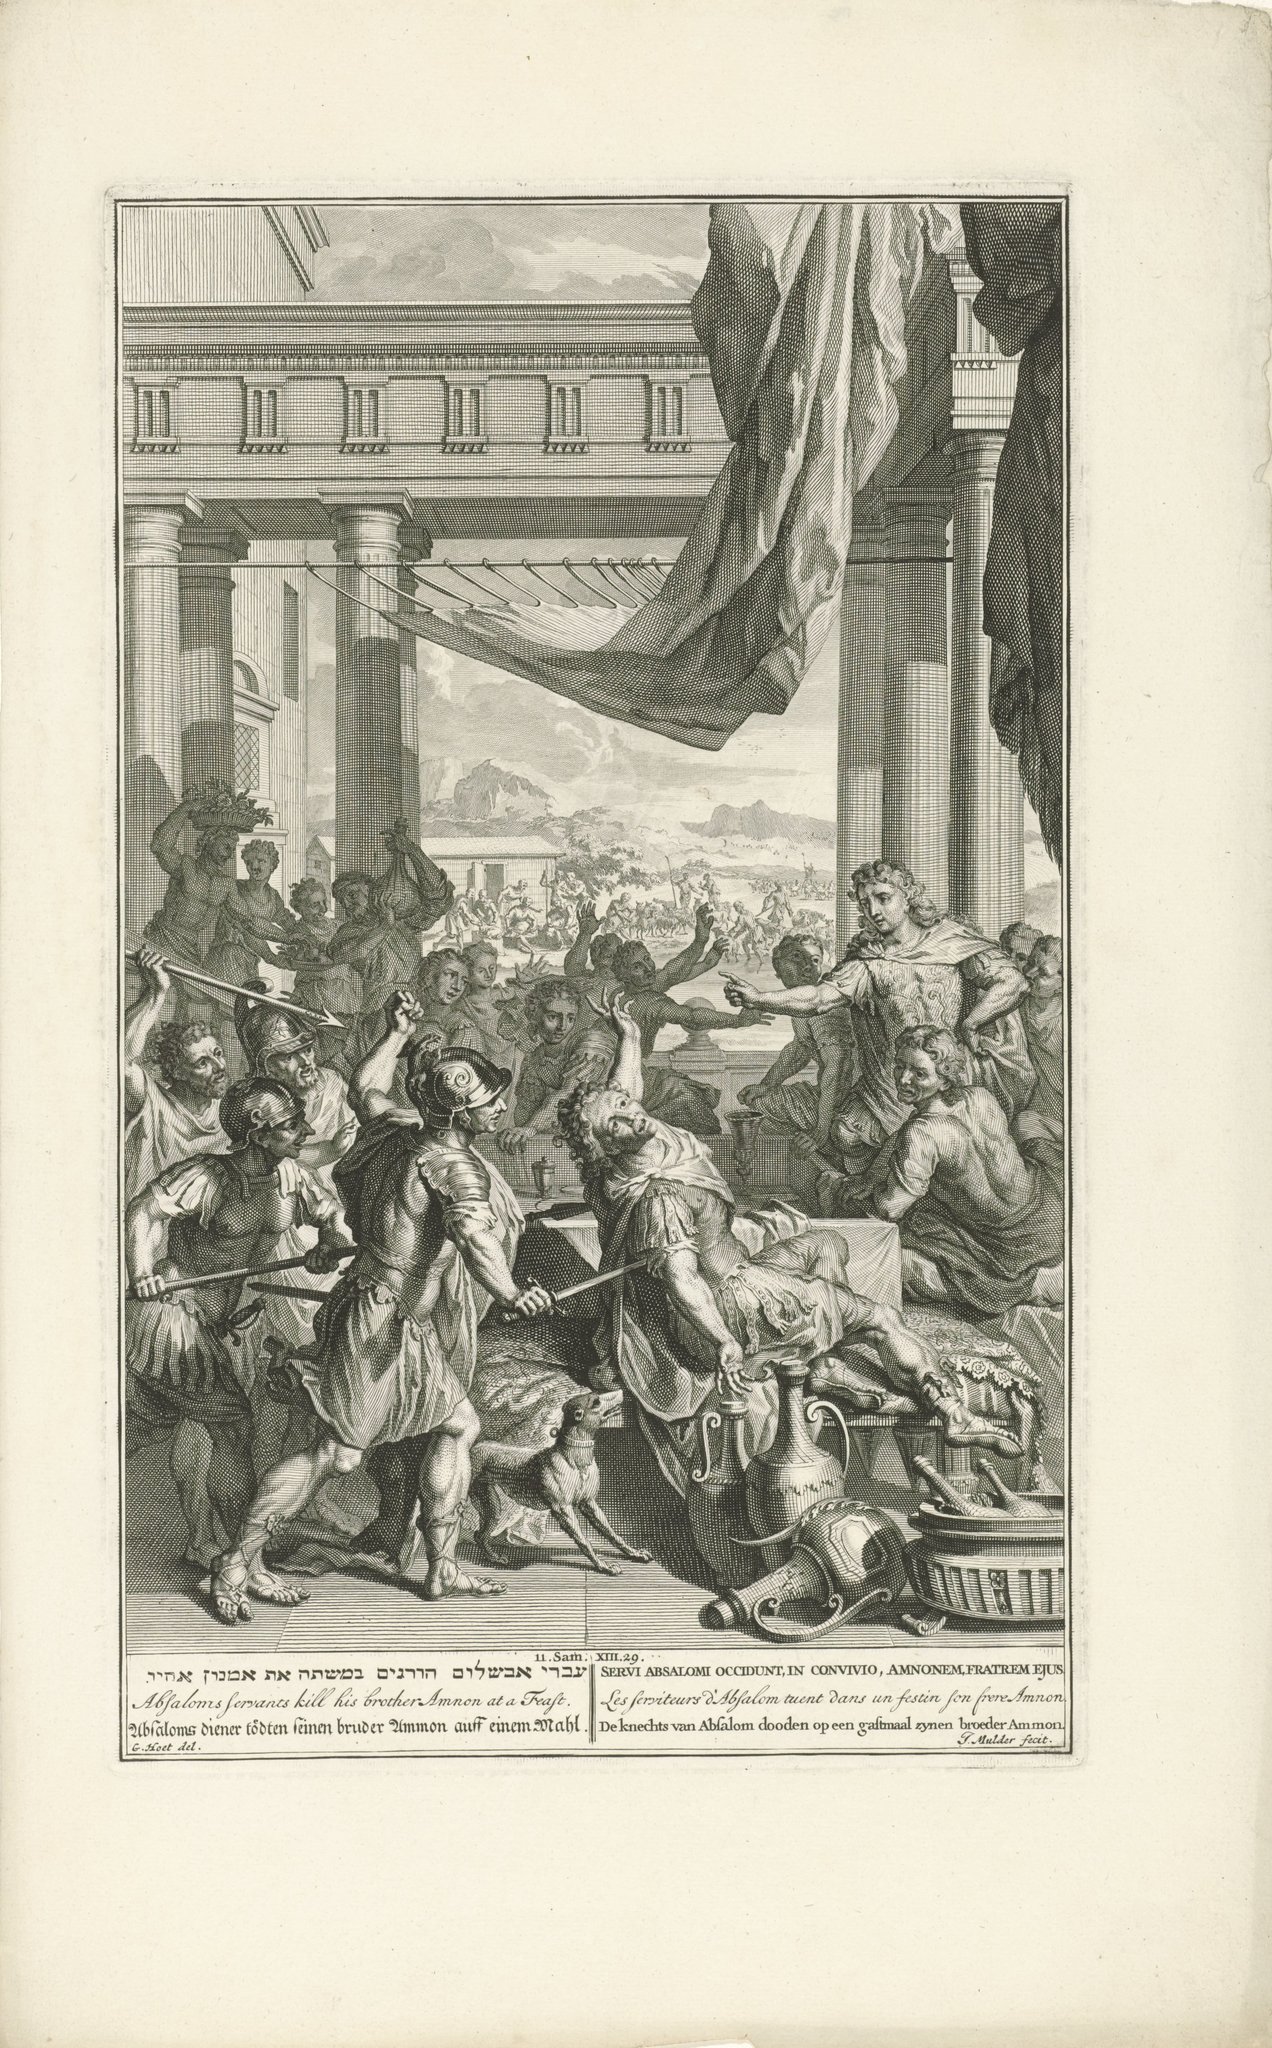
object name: book illustration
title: Absaloms knechten doden zijn broer Amnon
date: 1720-1728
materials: paper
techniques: engraving, etching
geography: amsterdam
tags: amnon is murdered at absalom's banquet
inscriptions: inscription: ‘Utrechts Fundatie huijs’, collector's mark: Lugt 2228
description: Prent gemaakt voor: Figures de la Bible. Amsterdam, Bernard Picart, 1720. Prent ook gebruikt in: Taferelen der voornaamste geschiedenissen van het Oude en Nieuwe Testament (...) door de vermaarde kunstenaars Hoet, Houbraken, en Picart getekent (...) en met beschrijvingen uitgebreid. Den Haag: Pieter de Hondt, 1728.